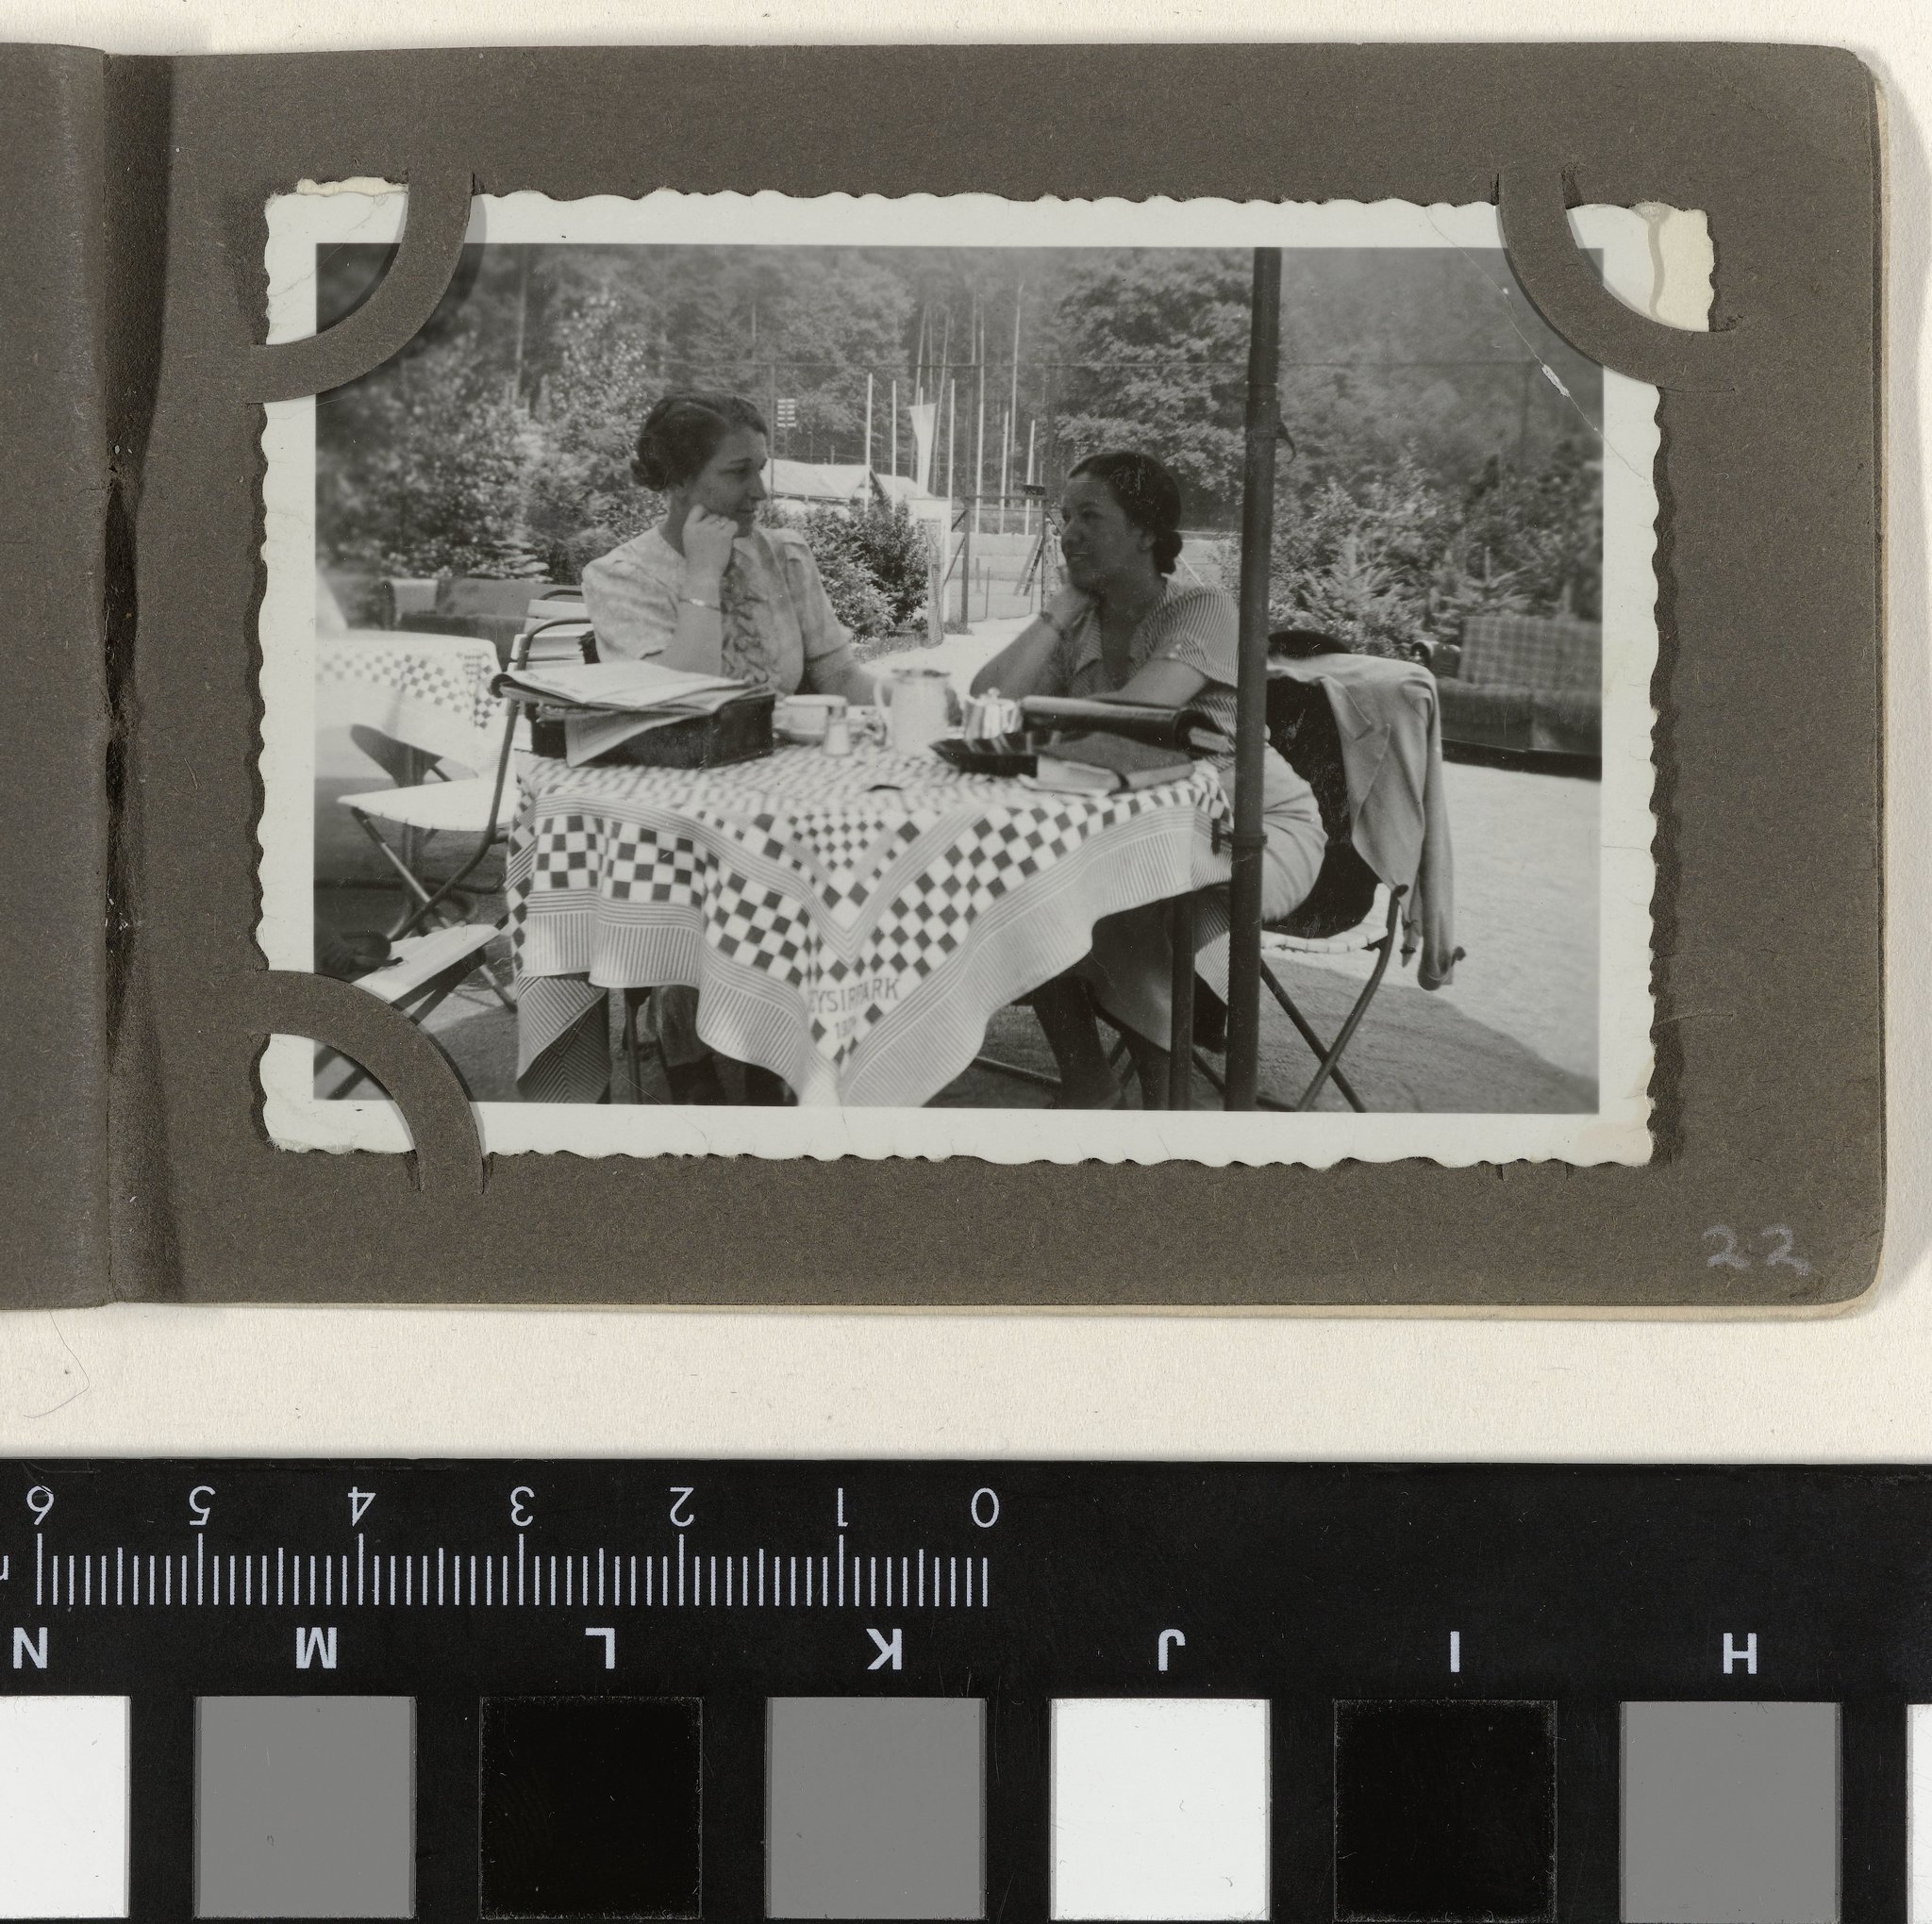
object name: photograph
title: Vrouwen aan tafel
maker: Anonymous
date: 1933-1944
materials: photographic support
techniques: gelatin silver print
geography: rotterdam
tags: wim van den bosch, rotterdam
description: Twee vrouwen zittend aan een tafel op een terras, waarschijnlijk bij een sportclub (tennis?). Onderdeel van het familiealbum 1933-1944.